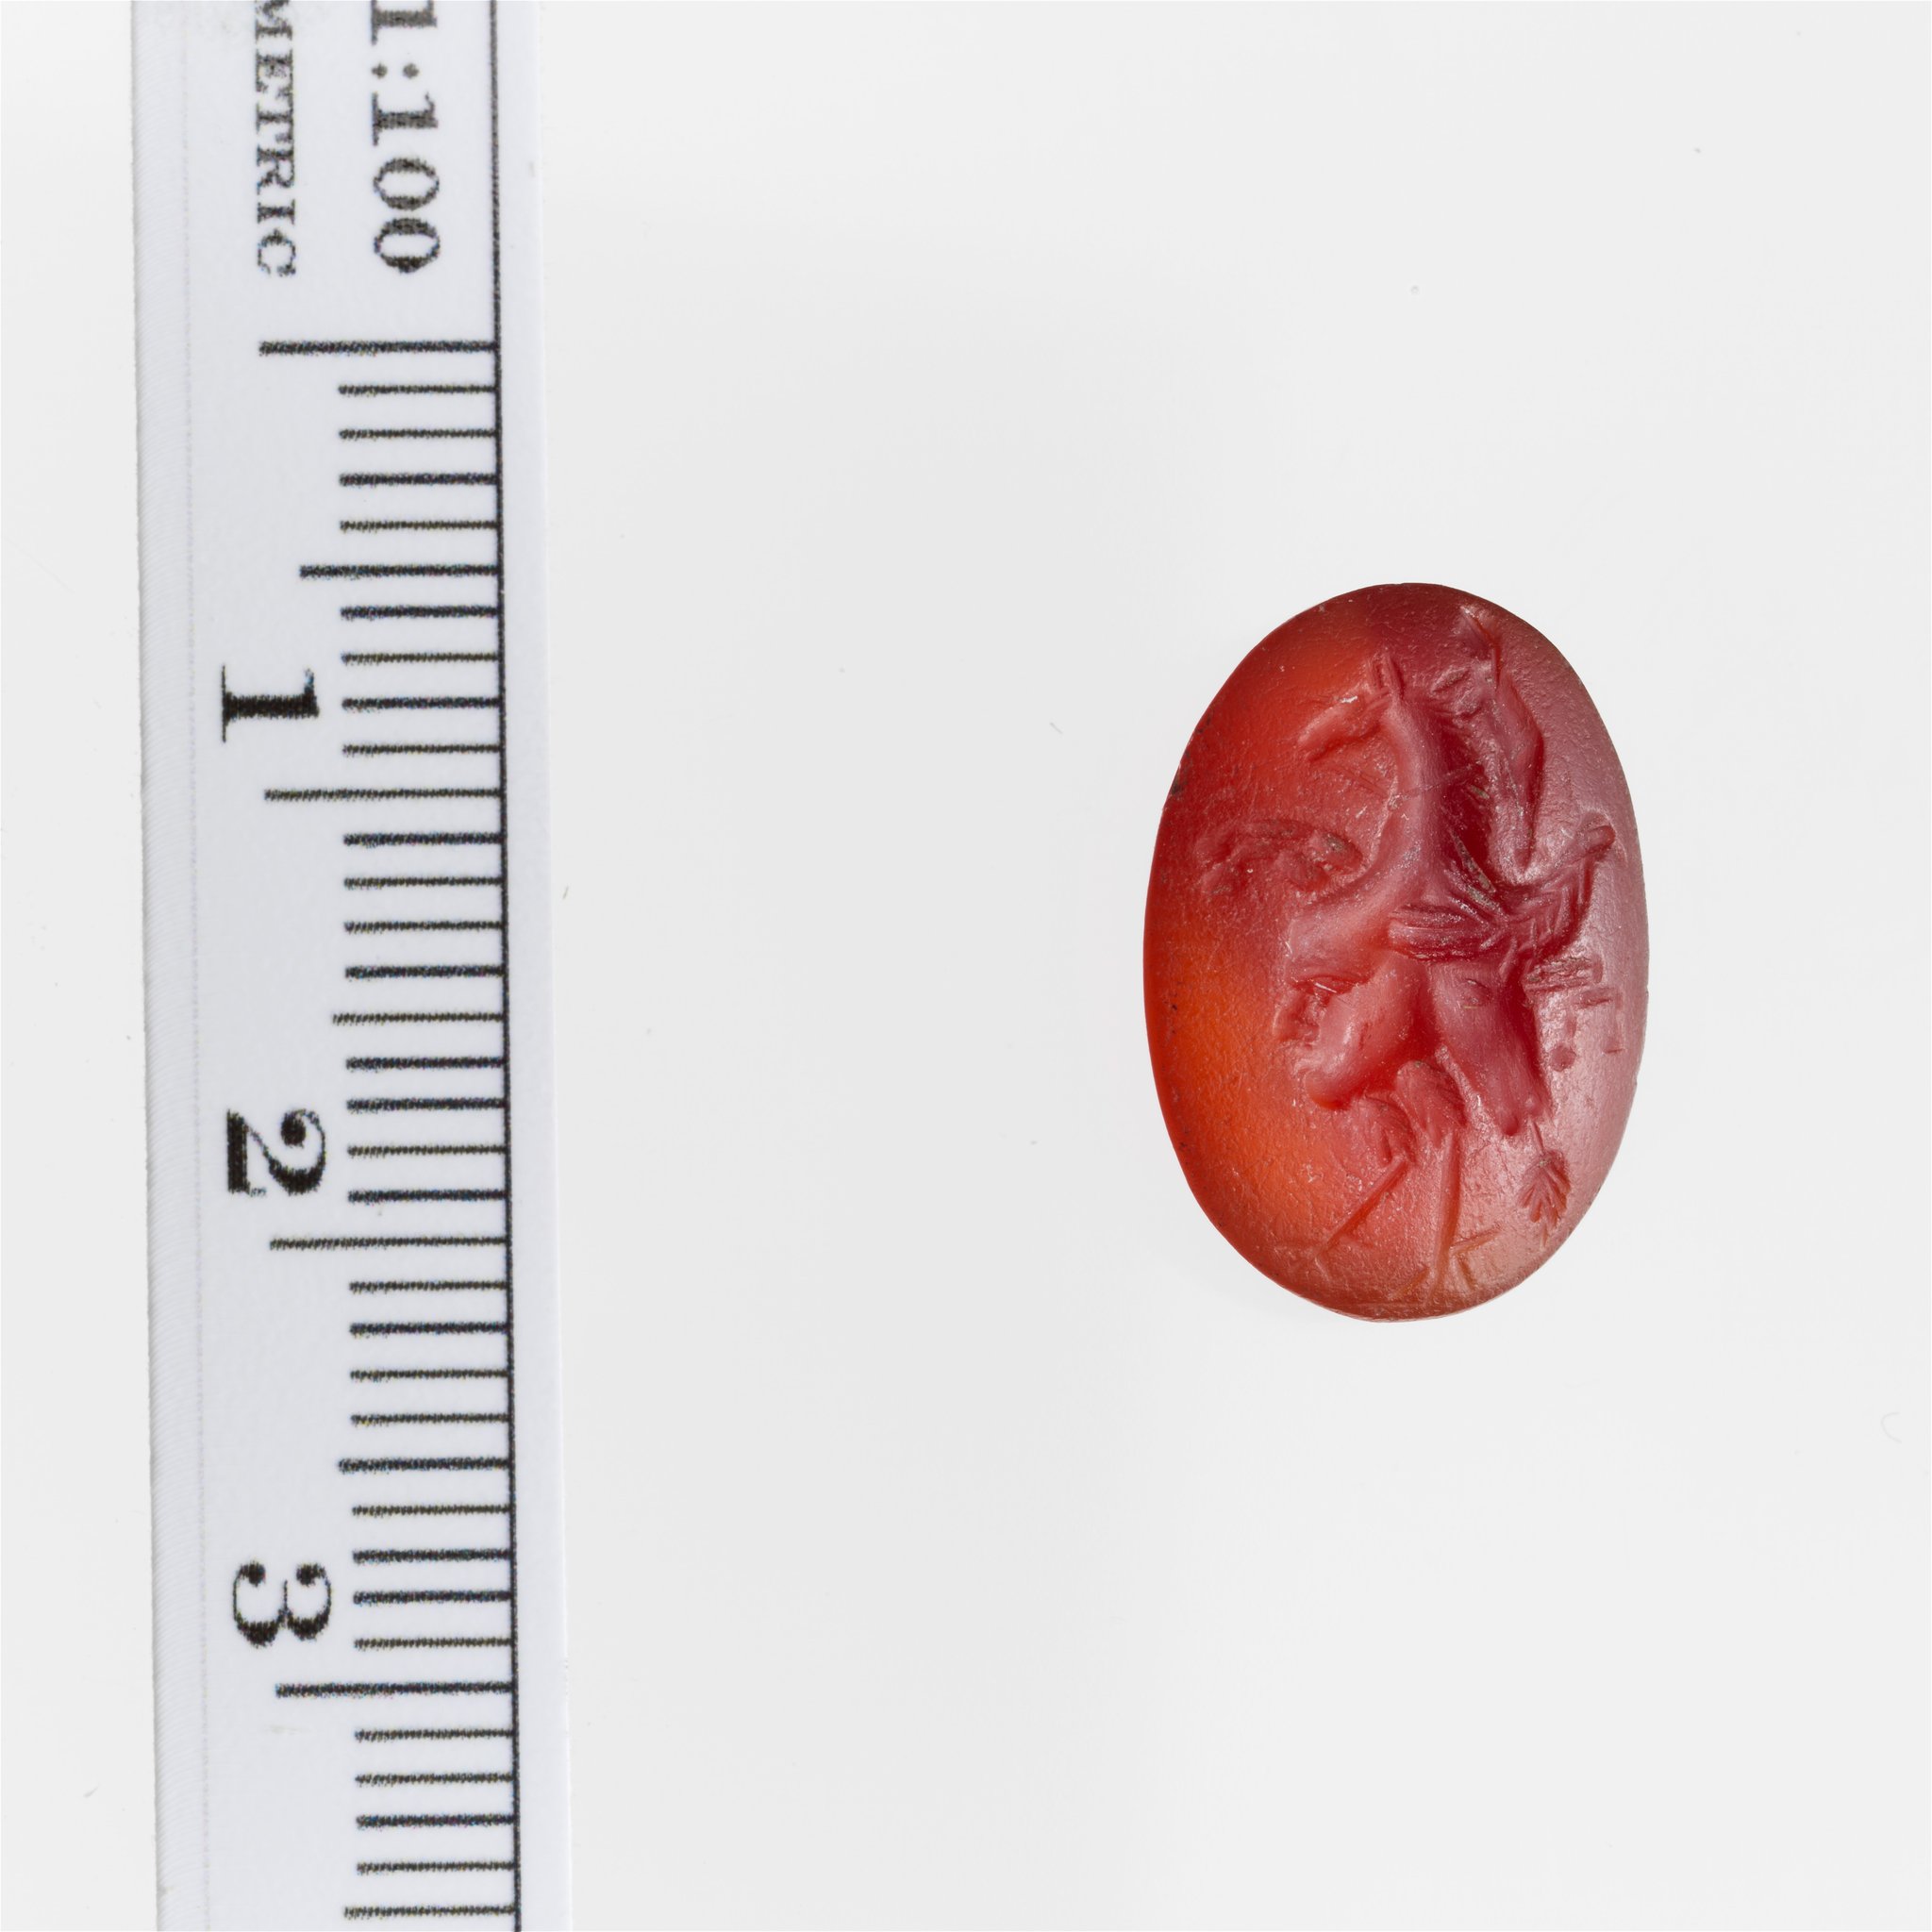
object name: intaglio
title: Carnelian ring stone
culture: roman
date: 200 BCE-300 CE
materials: gemstone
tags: human figures,animals